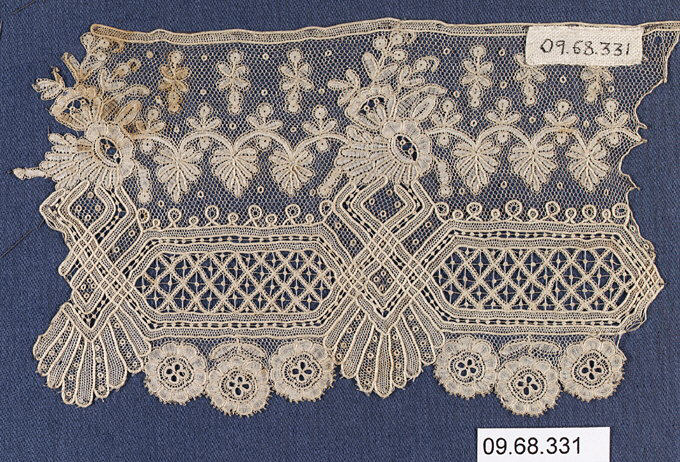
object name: fragment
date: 1801-1900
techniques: lace